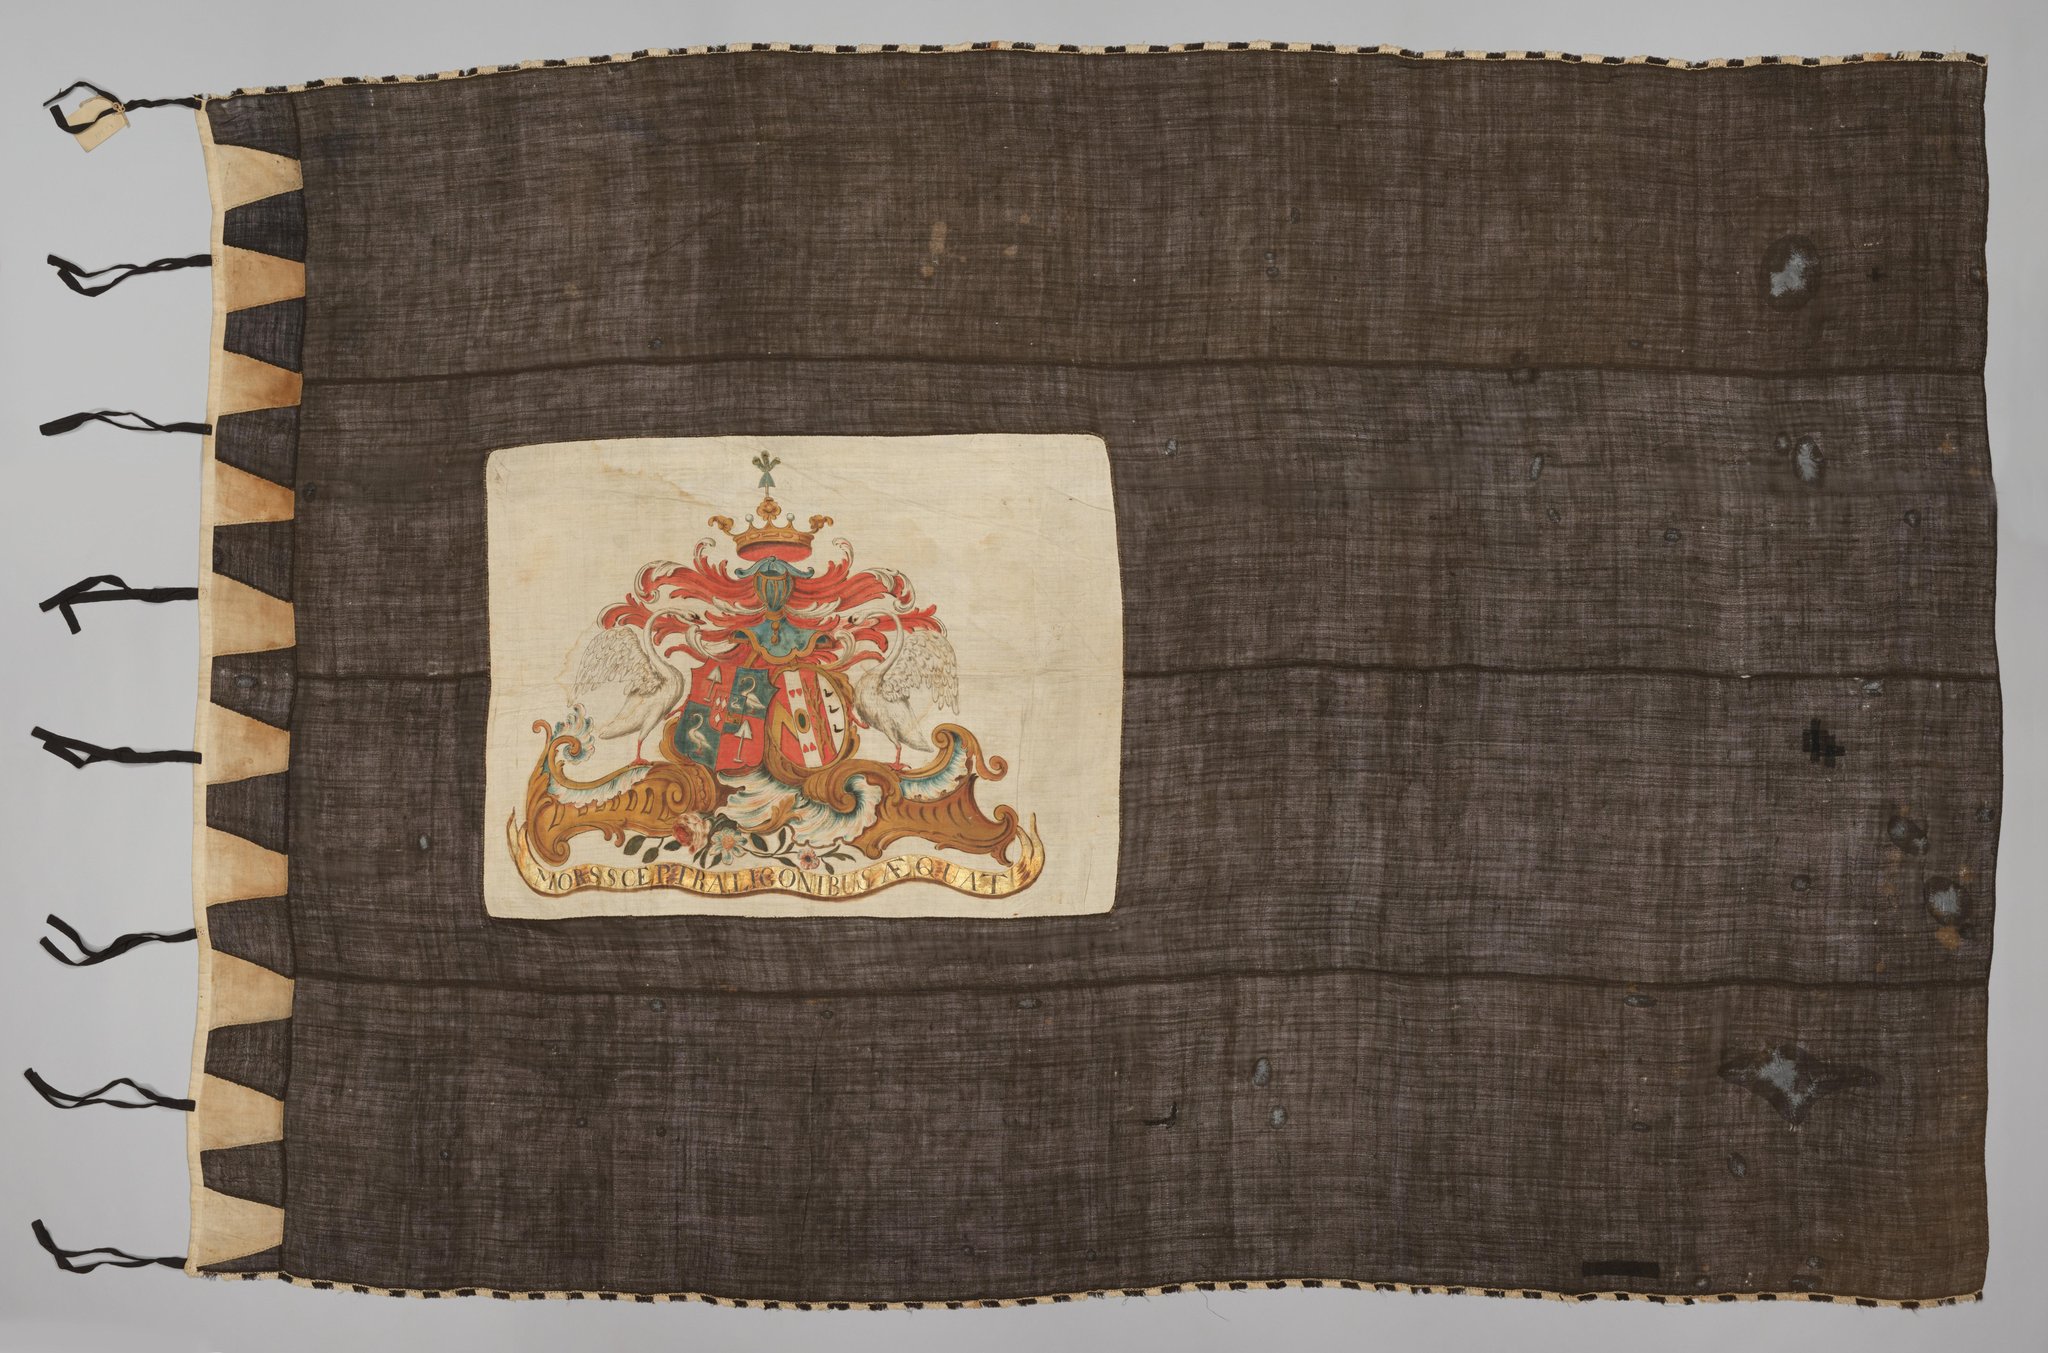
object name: flag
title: Zwarte vlag met wapen families De Graeff en Herzeele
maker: Anonymous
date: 1767-1798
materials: linen, paint, wool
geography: netherlands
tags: amsterdam, armorial bearing, heraldry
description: Zwarte vlag met excentrisch aan broekzijde een witte rechthoek, met de wapens van Gerrit de Graeff, en Christina van Herzeele, tezamen gebracht onder een helm in blauw met oker tegen rood lofwerk. Hierboven een kroon met vijf punten: drie met fleurons, twee met parels, afwisselend, en boven de middelste een rechtopstaande troffel met okerkleurige steel en blauwe schep. Te weerszijden van de wapens een zwaan die zijn kop in het rode lofwerk steekt. Dit alles staat op een asymmetrische voet met lofwerk. Hieronder een banderol in goud, waarop in zwarte klassieke kapitalen: MORS, SCEPTRA, LIGONIBUS, AEQUAT. Langs de broek aan baan van afgeknotte driehoeken in zwart en wit. Aan boven- en onderzijde zwart-witte franje. Acht stellen vernieuwde lintjes aan de broek.